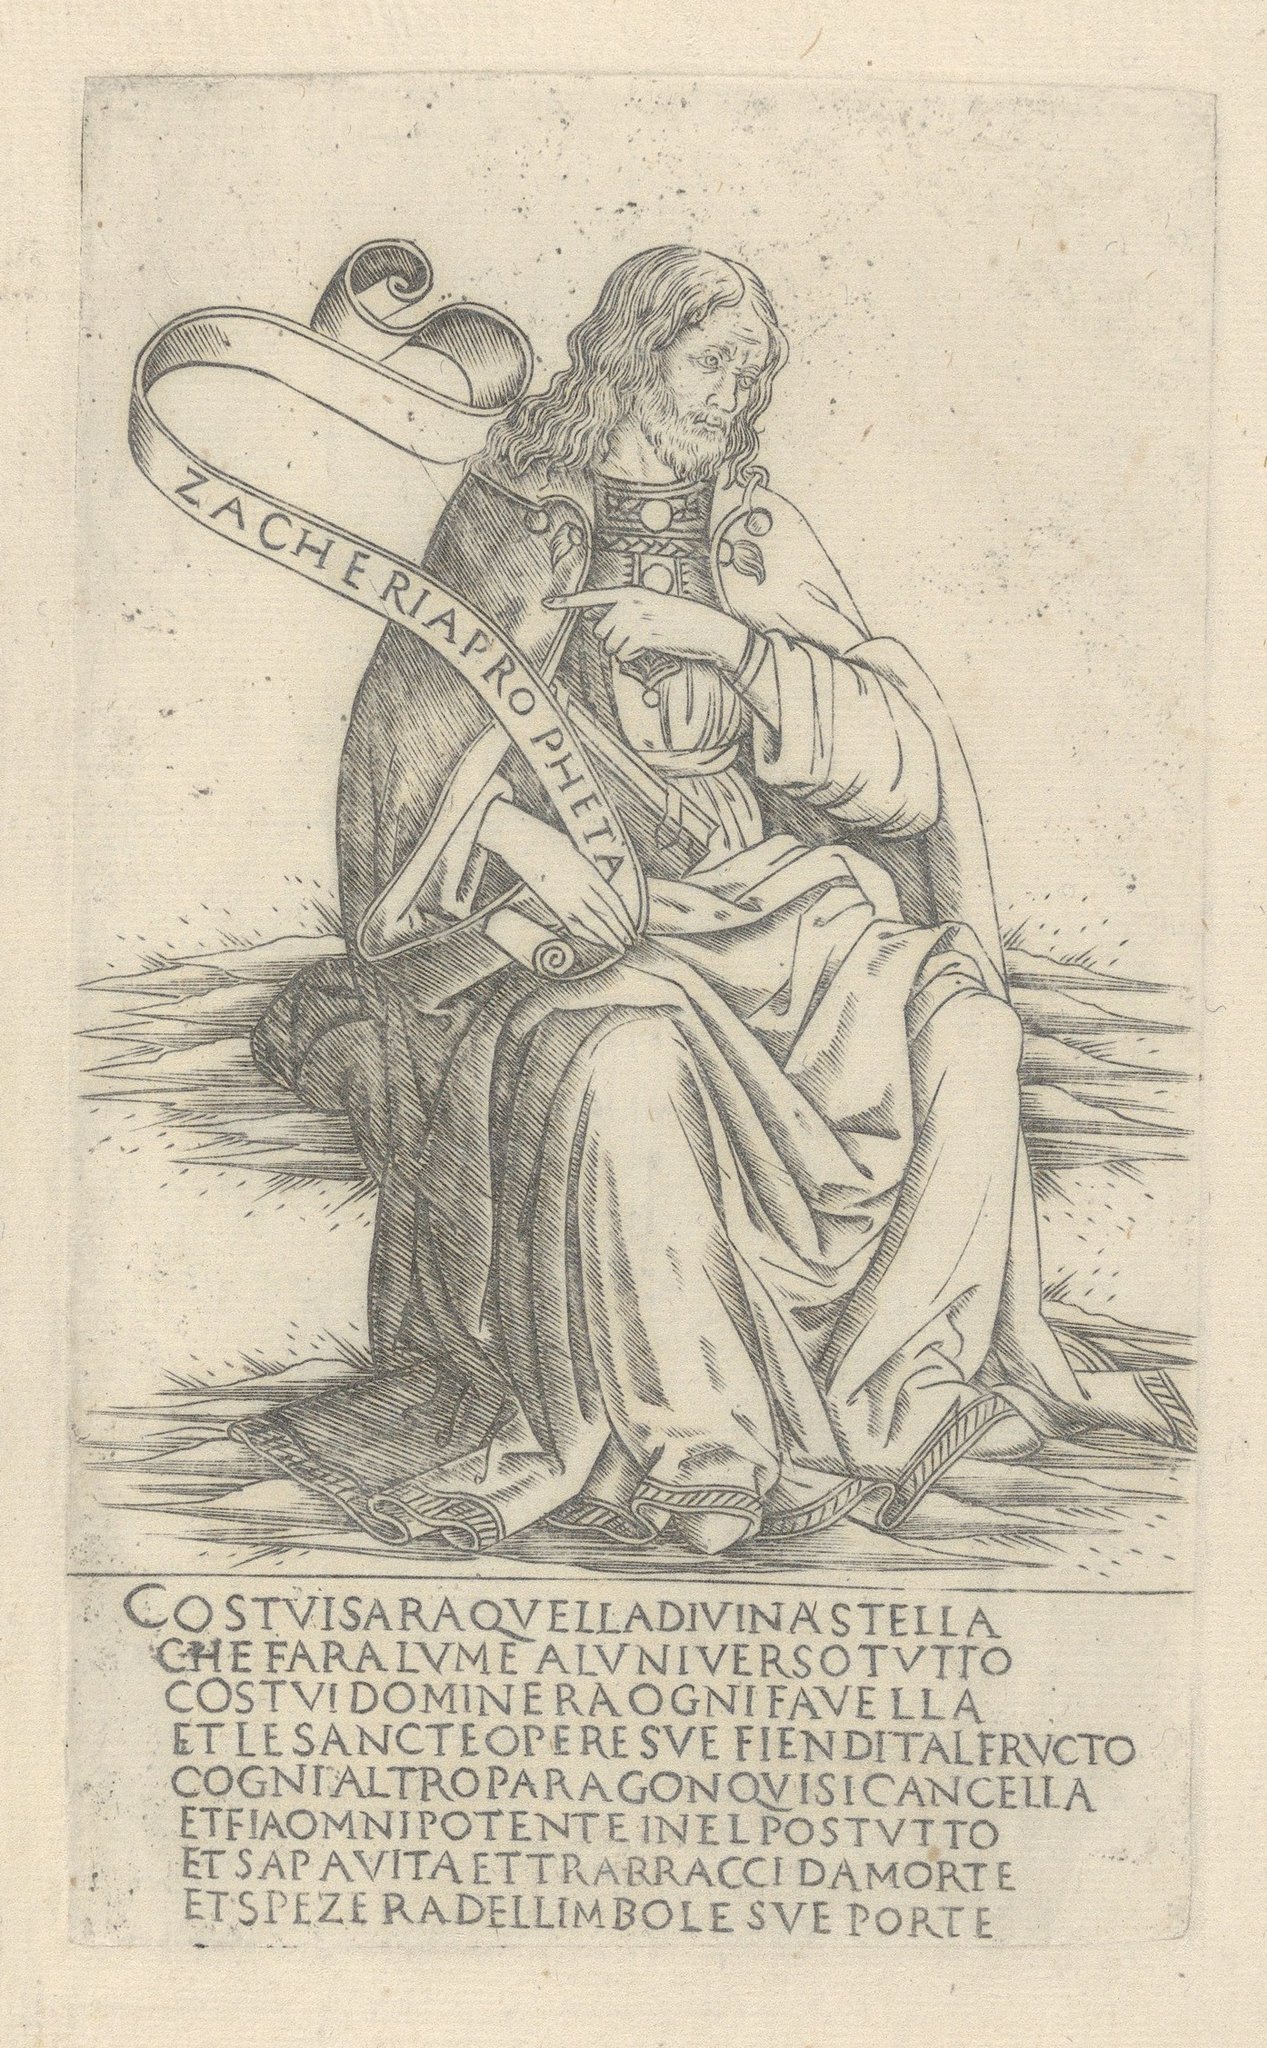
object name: print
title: The Prophet Zecheriah, from Prophets and Sibyls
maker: francesco rosselli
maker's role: artist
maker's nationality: italian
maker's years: 1448-1527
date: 1480-1490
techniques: engraving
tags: men